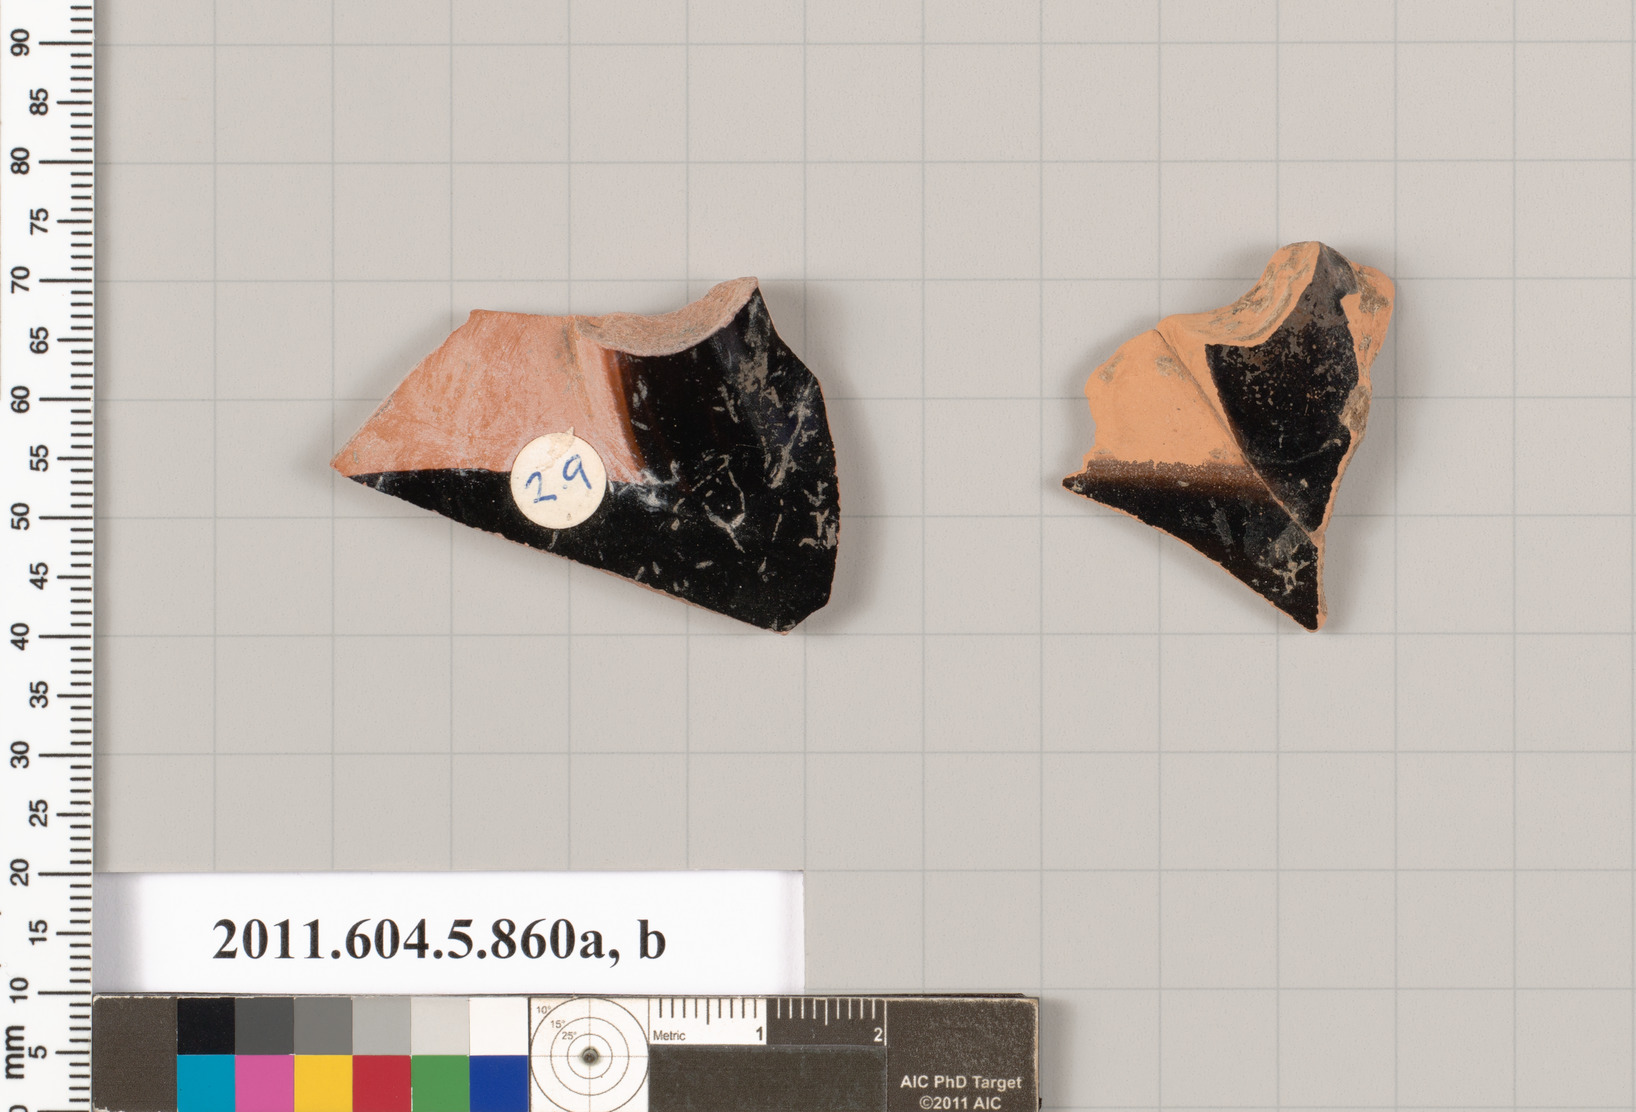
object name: kylix fragment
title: Terracotta fragments of kylikes (drinking cups)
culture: greek, attic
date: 600-401 BCE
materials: terracotta